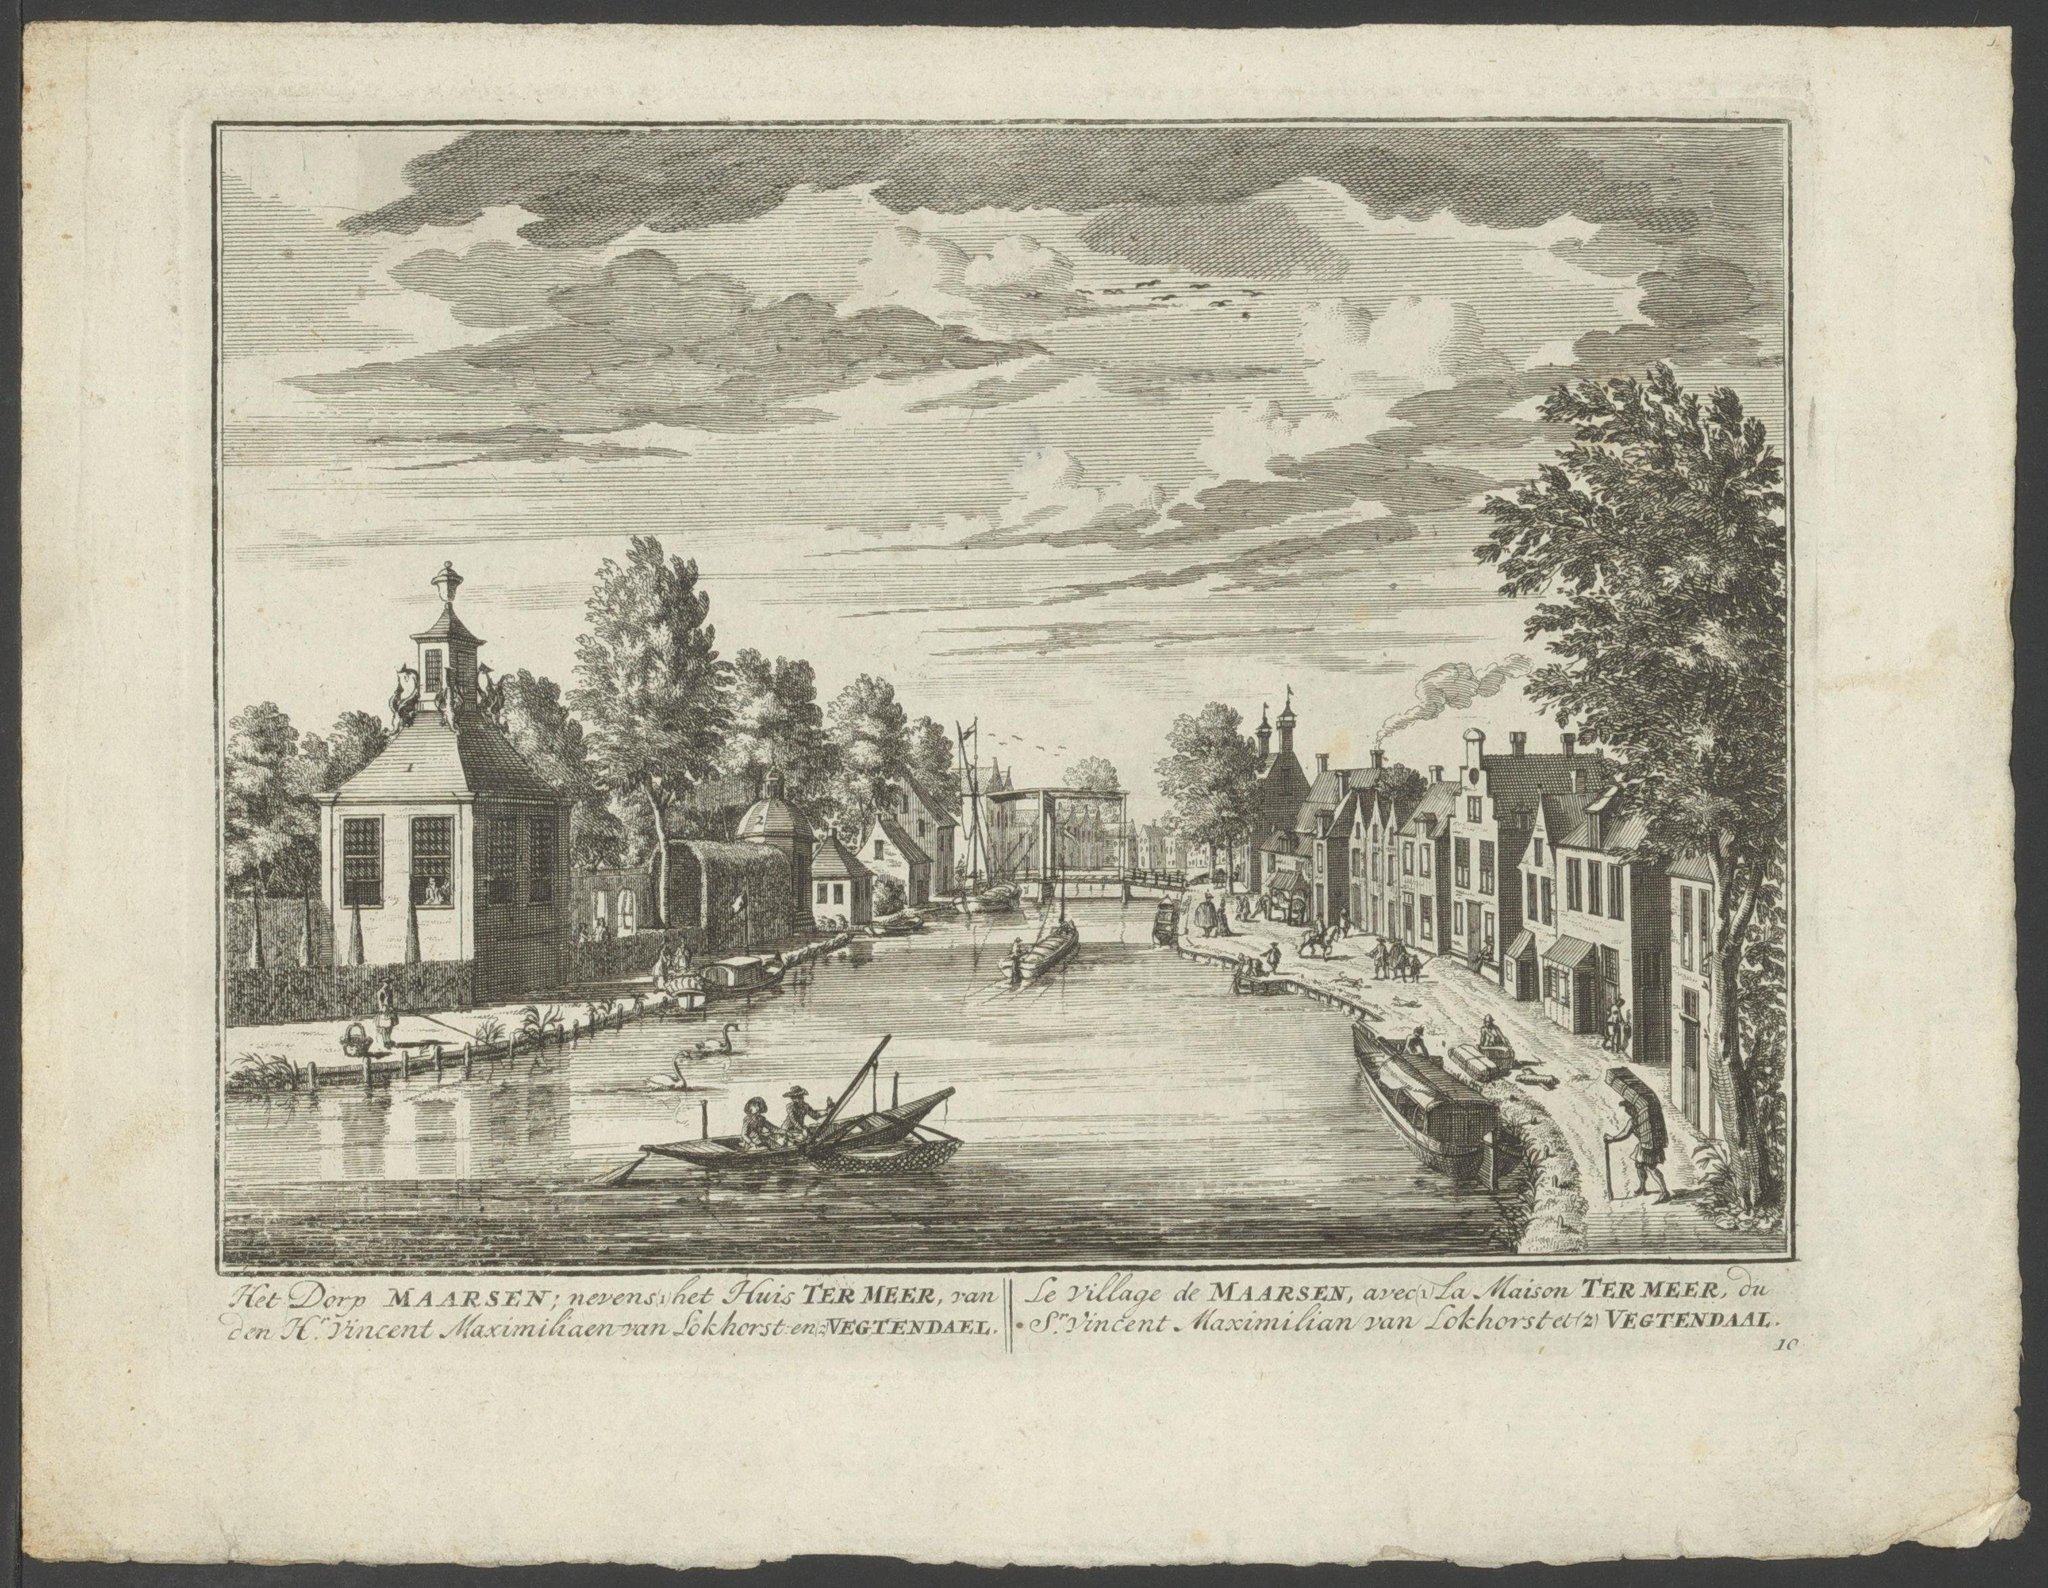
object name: print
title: Gezicht op de Vecht door Maarssen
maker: daniël stopendaal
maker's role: print maker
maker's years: 1672-1726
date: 1790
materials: paper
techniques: engraving, etching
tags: river (+ landscape with figures, staffage), village (+ city(-scape) with figures, staffage), maarssen, vecht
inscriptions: inscription: ‘Doublet’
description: Prent voor het eerst gebruikt in: Leth, Andries de. De zegepraalende Vecht, vertoonende verscheidene gesichten van lustplaatsen, heeren huysen en dorpen, beginnende van Uitrecht en met Muyden besluytende (...). Amsterdam: Weduwe Nicolaus Visscher, 1719. Prent mogelijk uit: Brouërius van Nidek, Matthaeus. De Vechtstroom, van Utrecht tot Muiden (...). Amsterdam: H. Gartman, W. Vermandel en J.W. Smit, 1790.